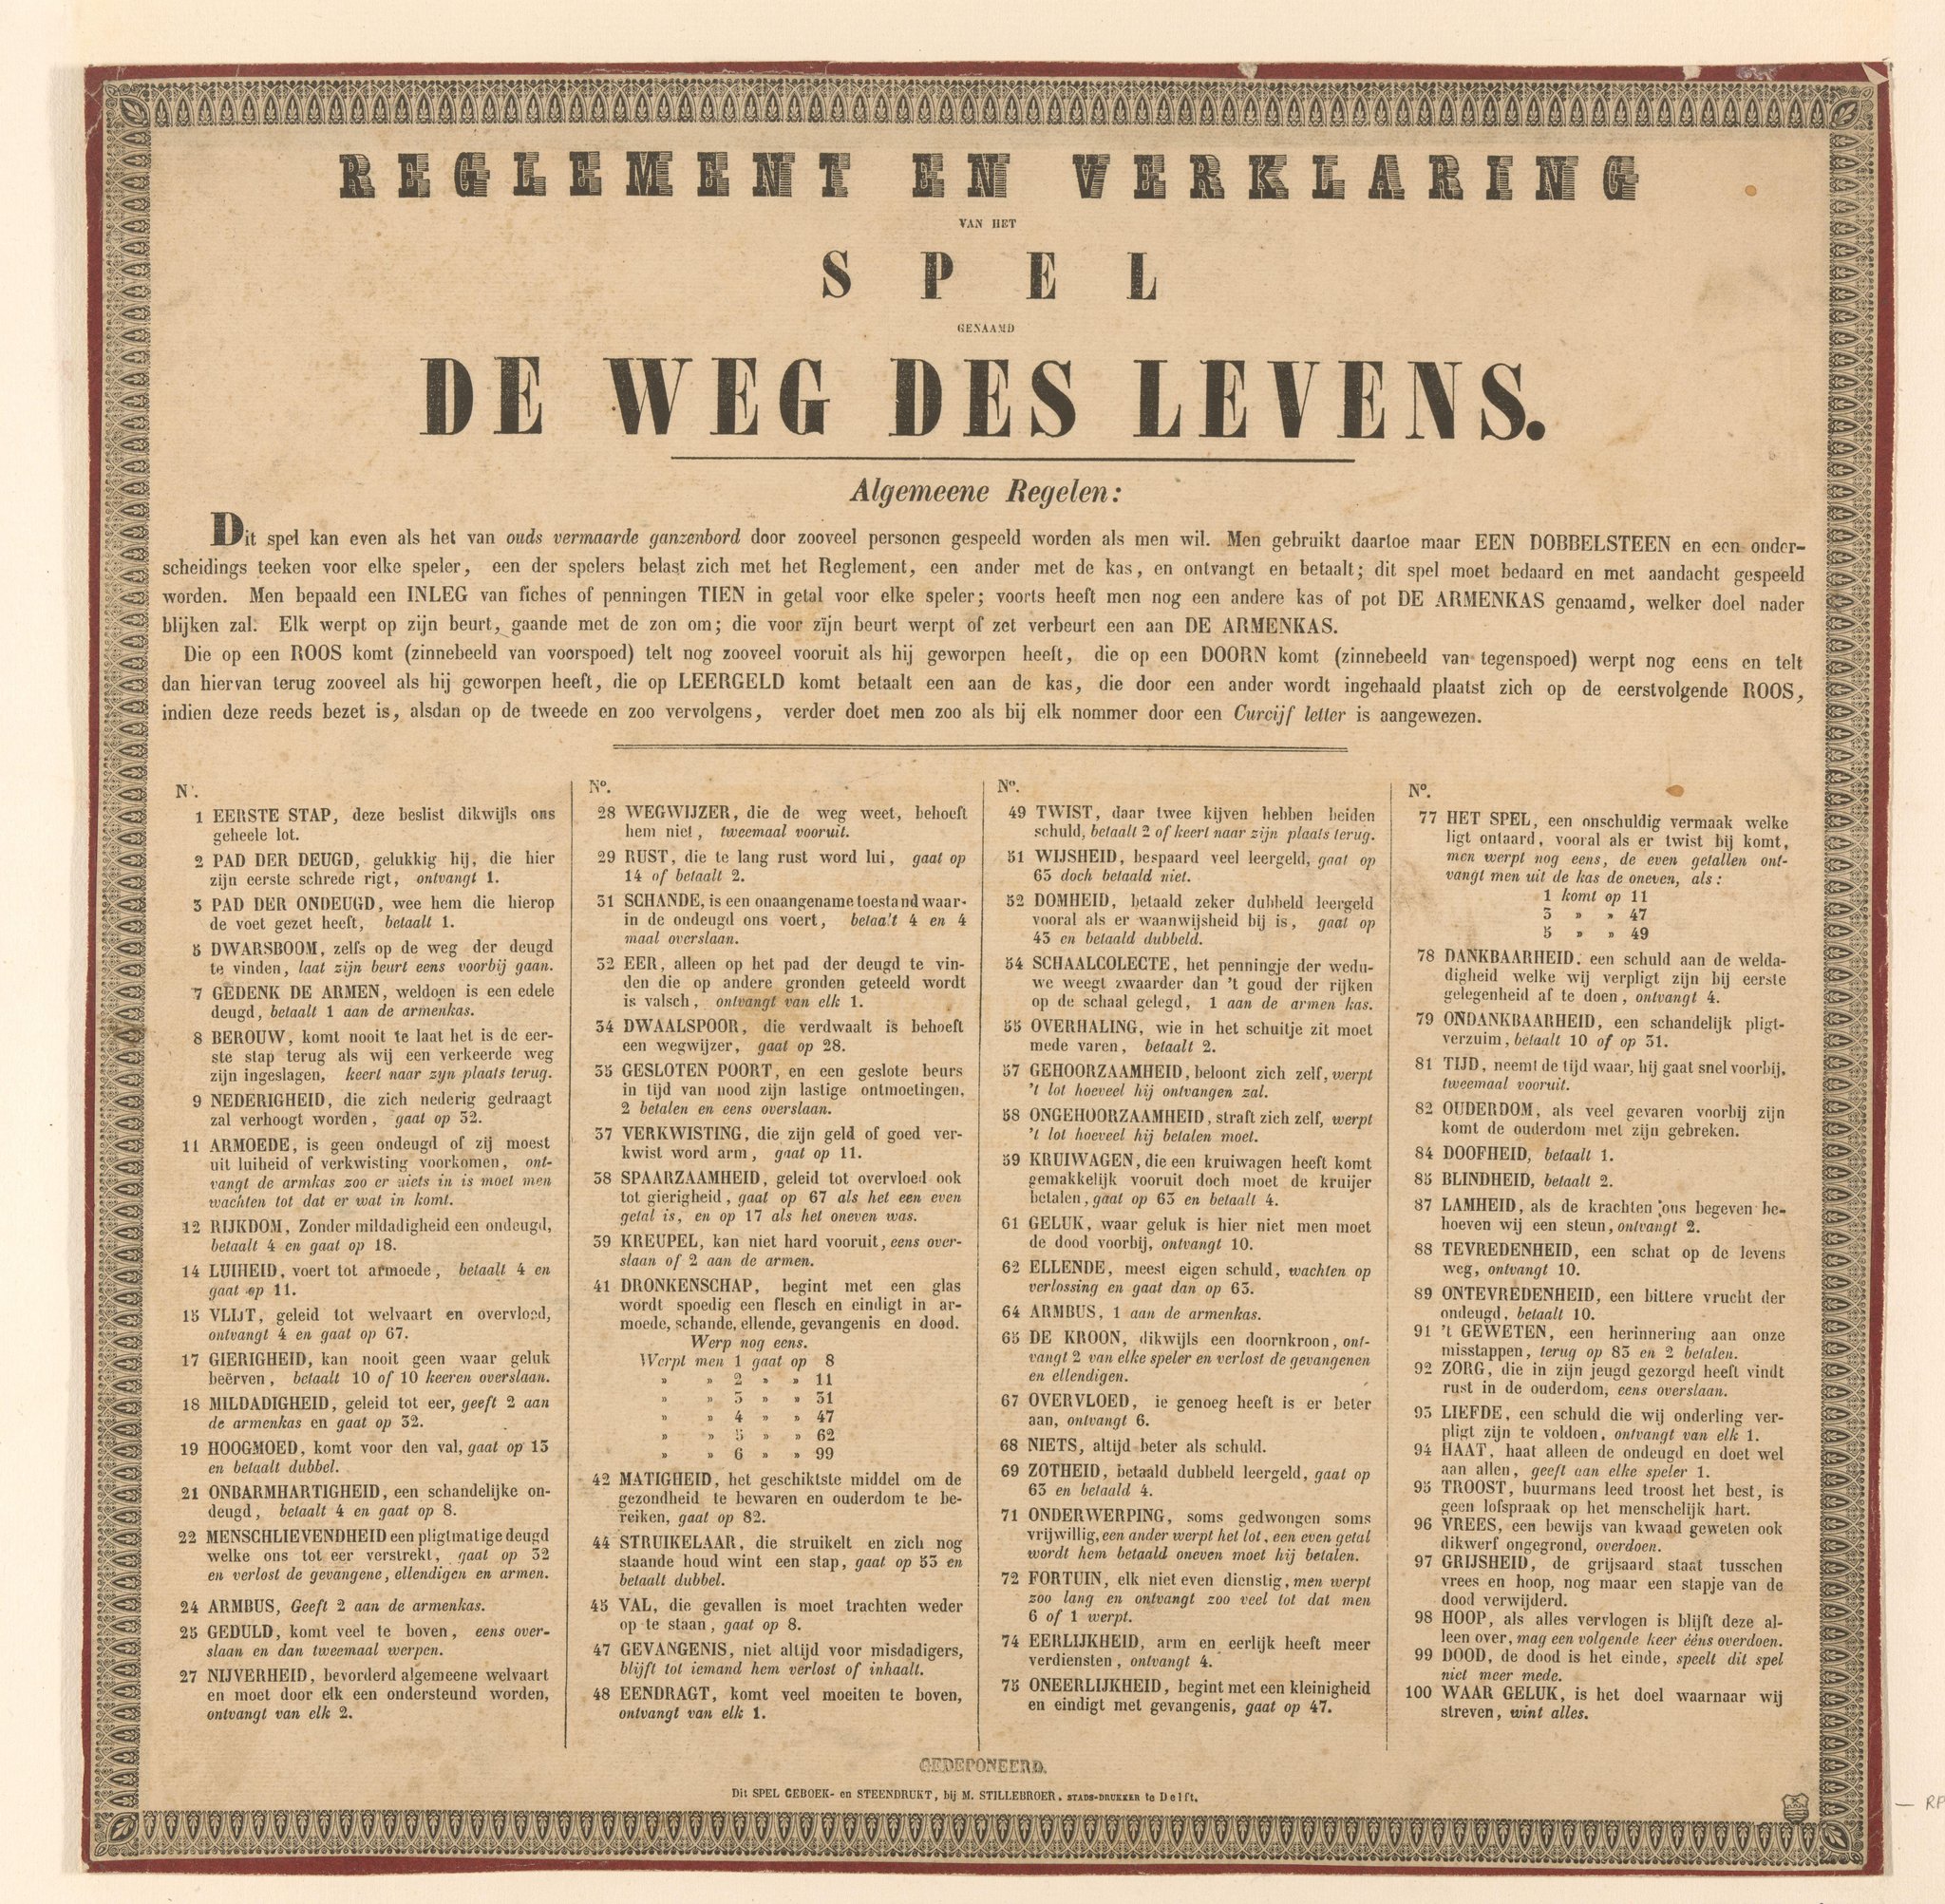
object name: text sheet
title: Reglement en verklaring / van het / Spel / genaamd / De weg des levens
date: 1838-1865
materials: cardboard, paper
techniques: letterpress printing, lithograph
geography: delft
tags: board-games of chance, board-games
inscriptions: collector's mark: Lugt 2760